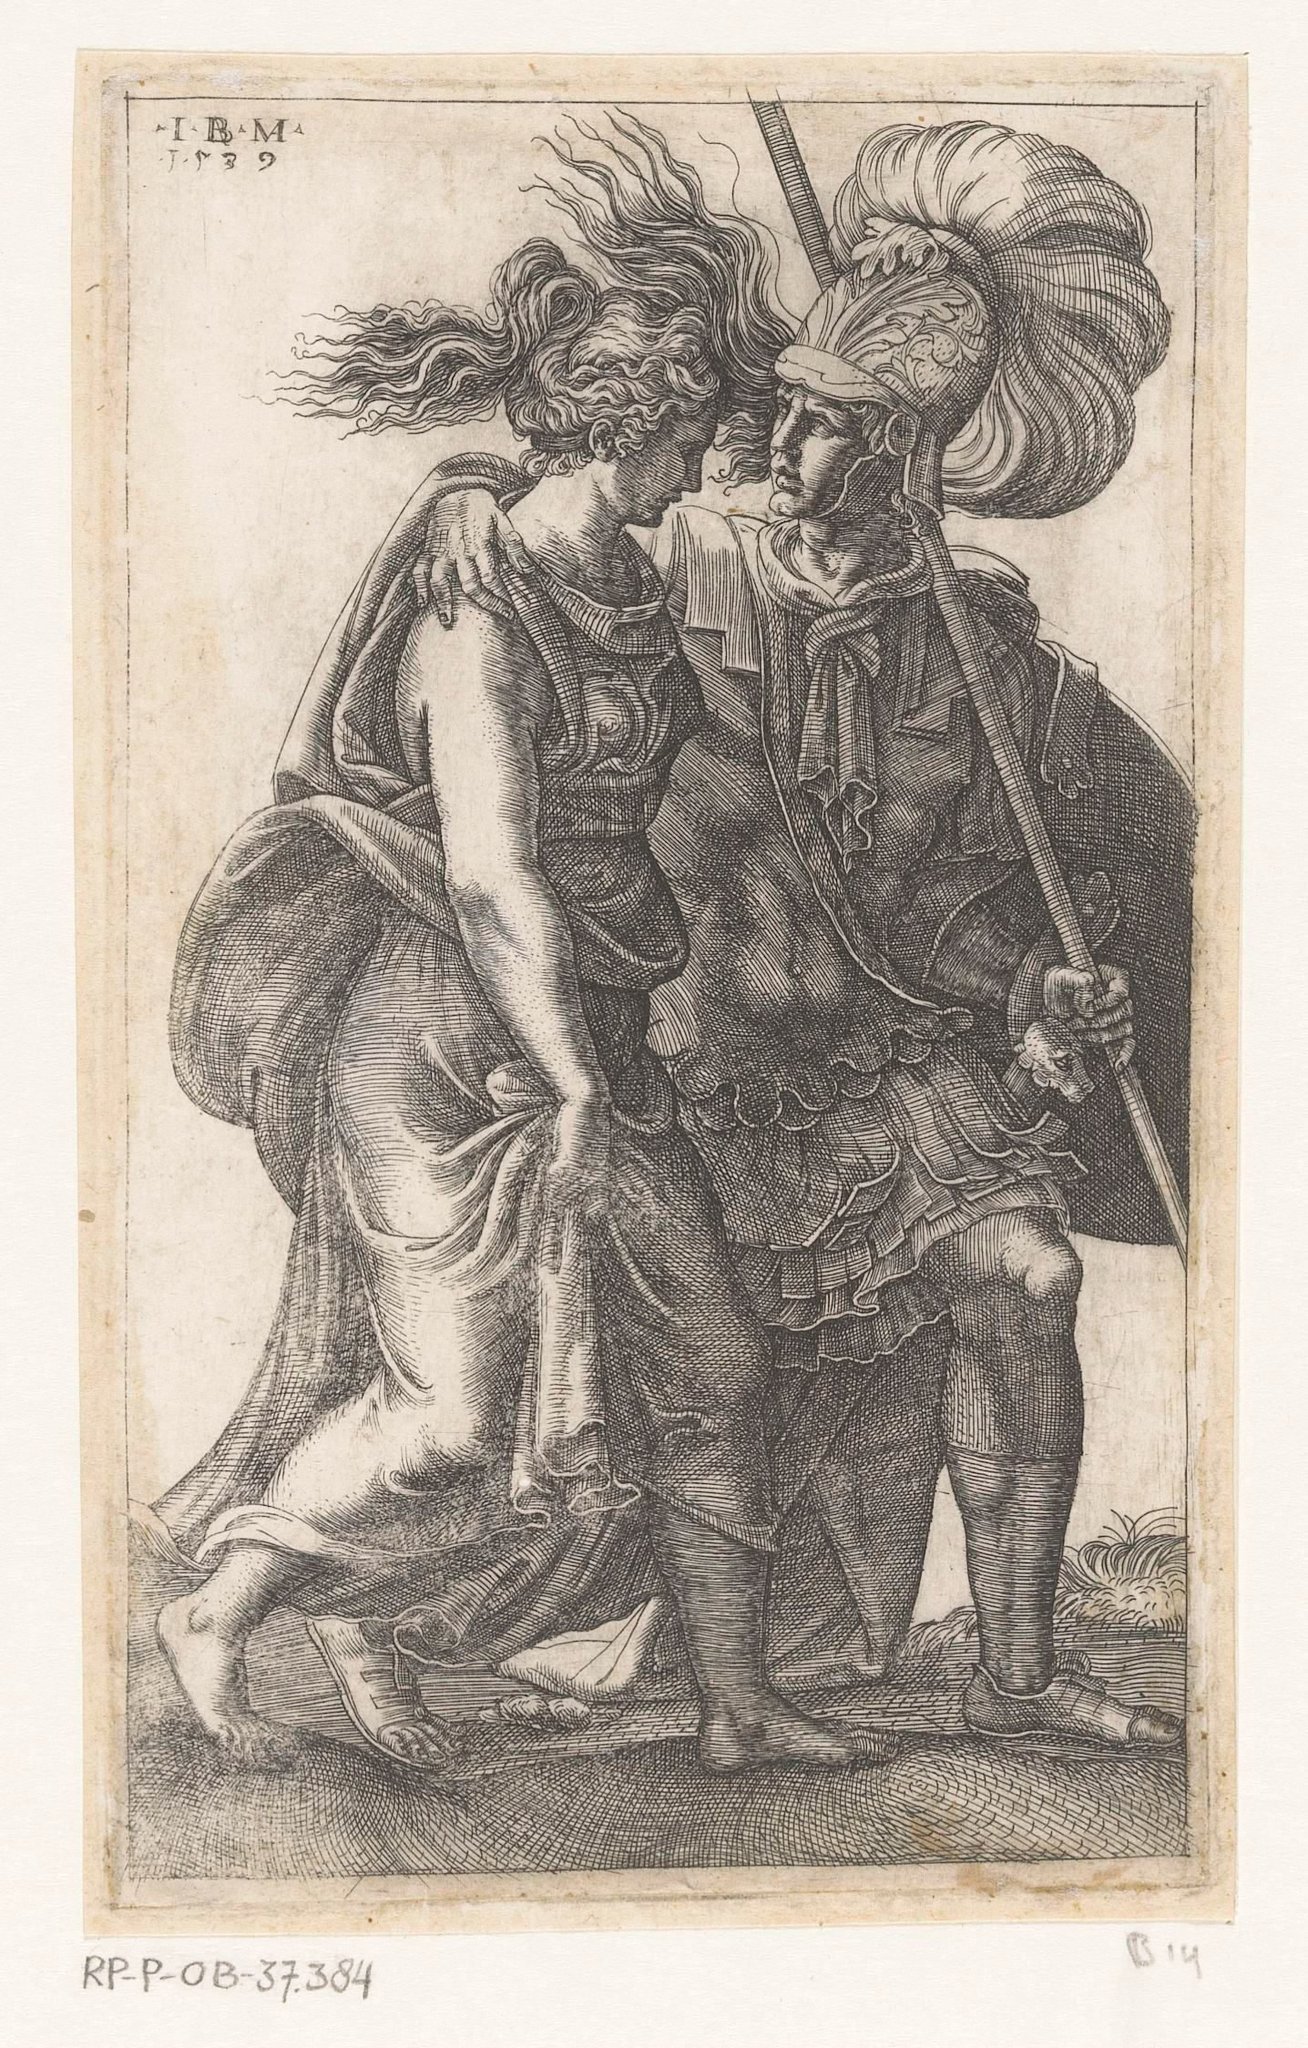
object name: print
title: Strijder en vrouw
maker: giovanni battista scultori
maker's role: print maker, sculptor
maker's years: 1503-1575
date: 1539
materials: paper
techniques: engraving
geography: italy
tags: armour, walking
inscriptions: collector's mark: Lugt 240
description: Een strijder gekleed in wapenrusting, lopend samen met een vrouw.